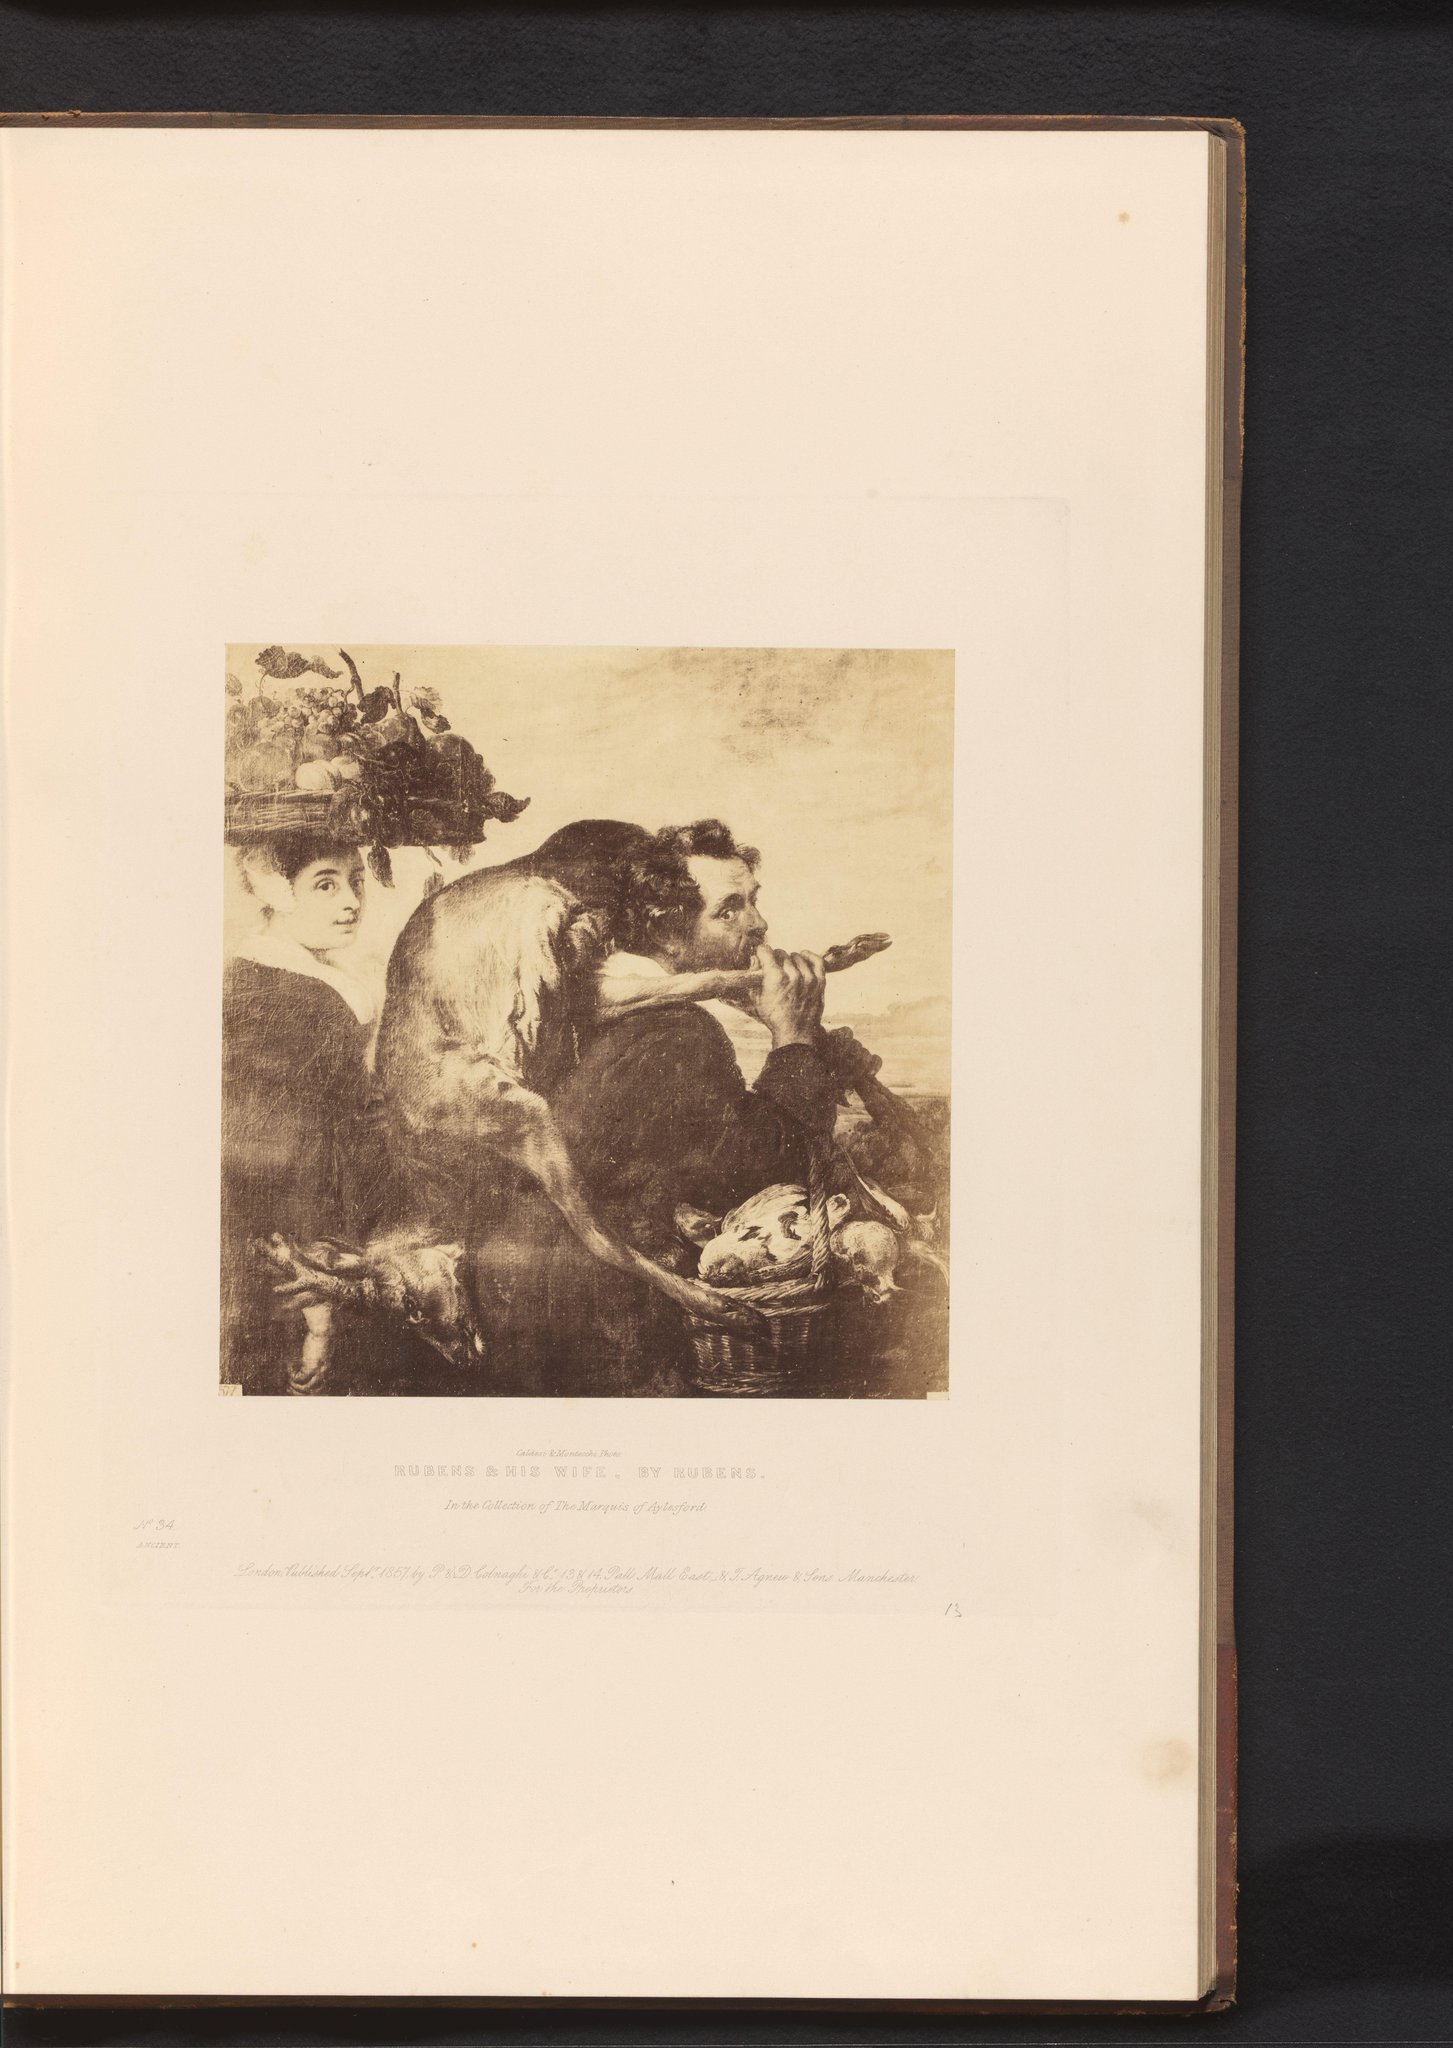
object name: photograph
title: Fotoreproductie van een schilderij van de schilder en zijn vrouw door Peter Paul Rubens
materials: photographic support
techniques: albumen print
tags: antwerp, painter, print maker, draughtsman, peter paul rubens, portrait, self-portrait of painter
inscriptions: inscription: ‘In the Collection of The Marquis of Aylesford./ London, Published Septr, 1857, by P. & D. Colnaghi & Co, 13 & 14, Pall Mall East & T. Agneur & Sons, Manchester./ For the Proprietors.’, number: ‘No. 34./ ANCIENT.’, number: ‘13’